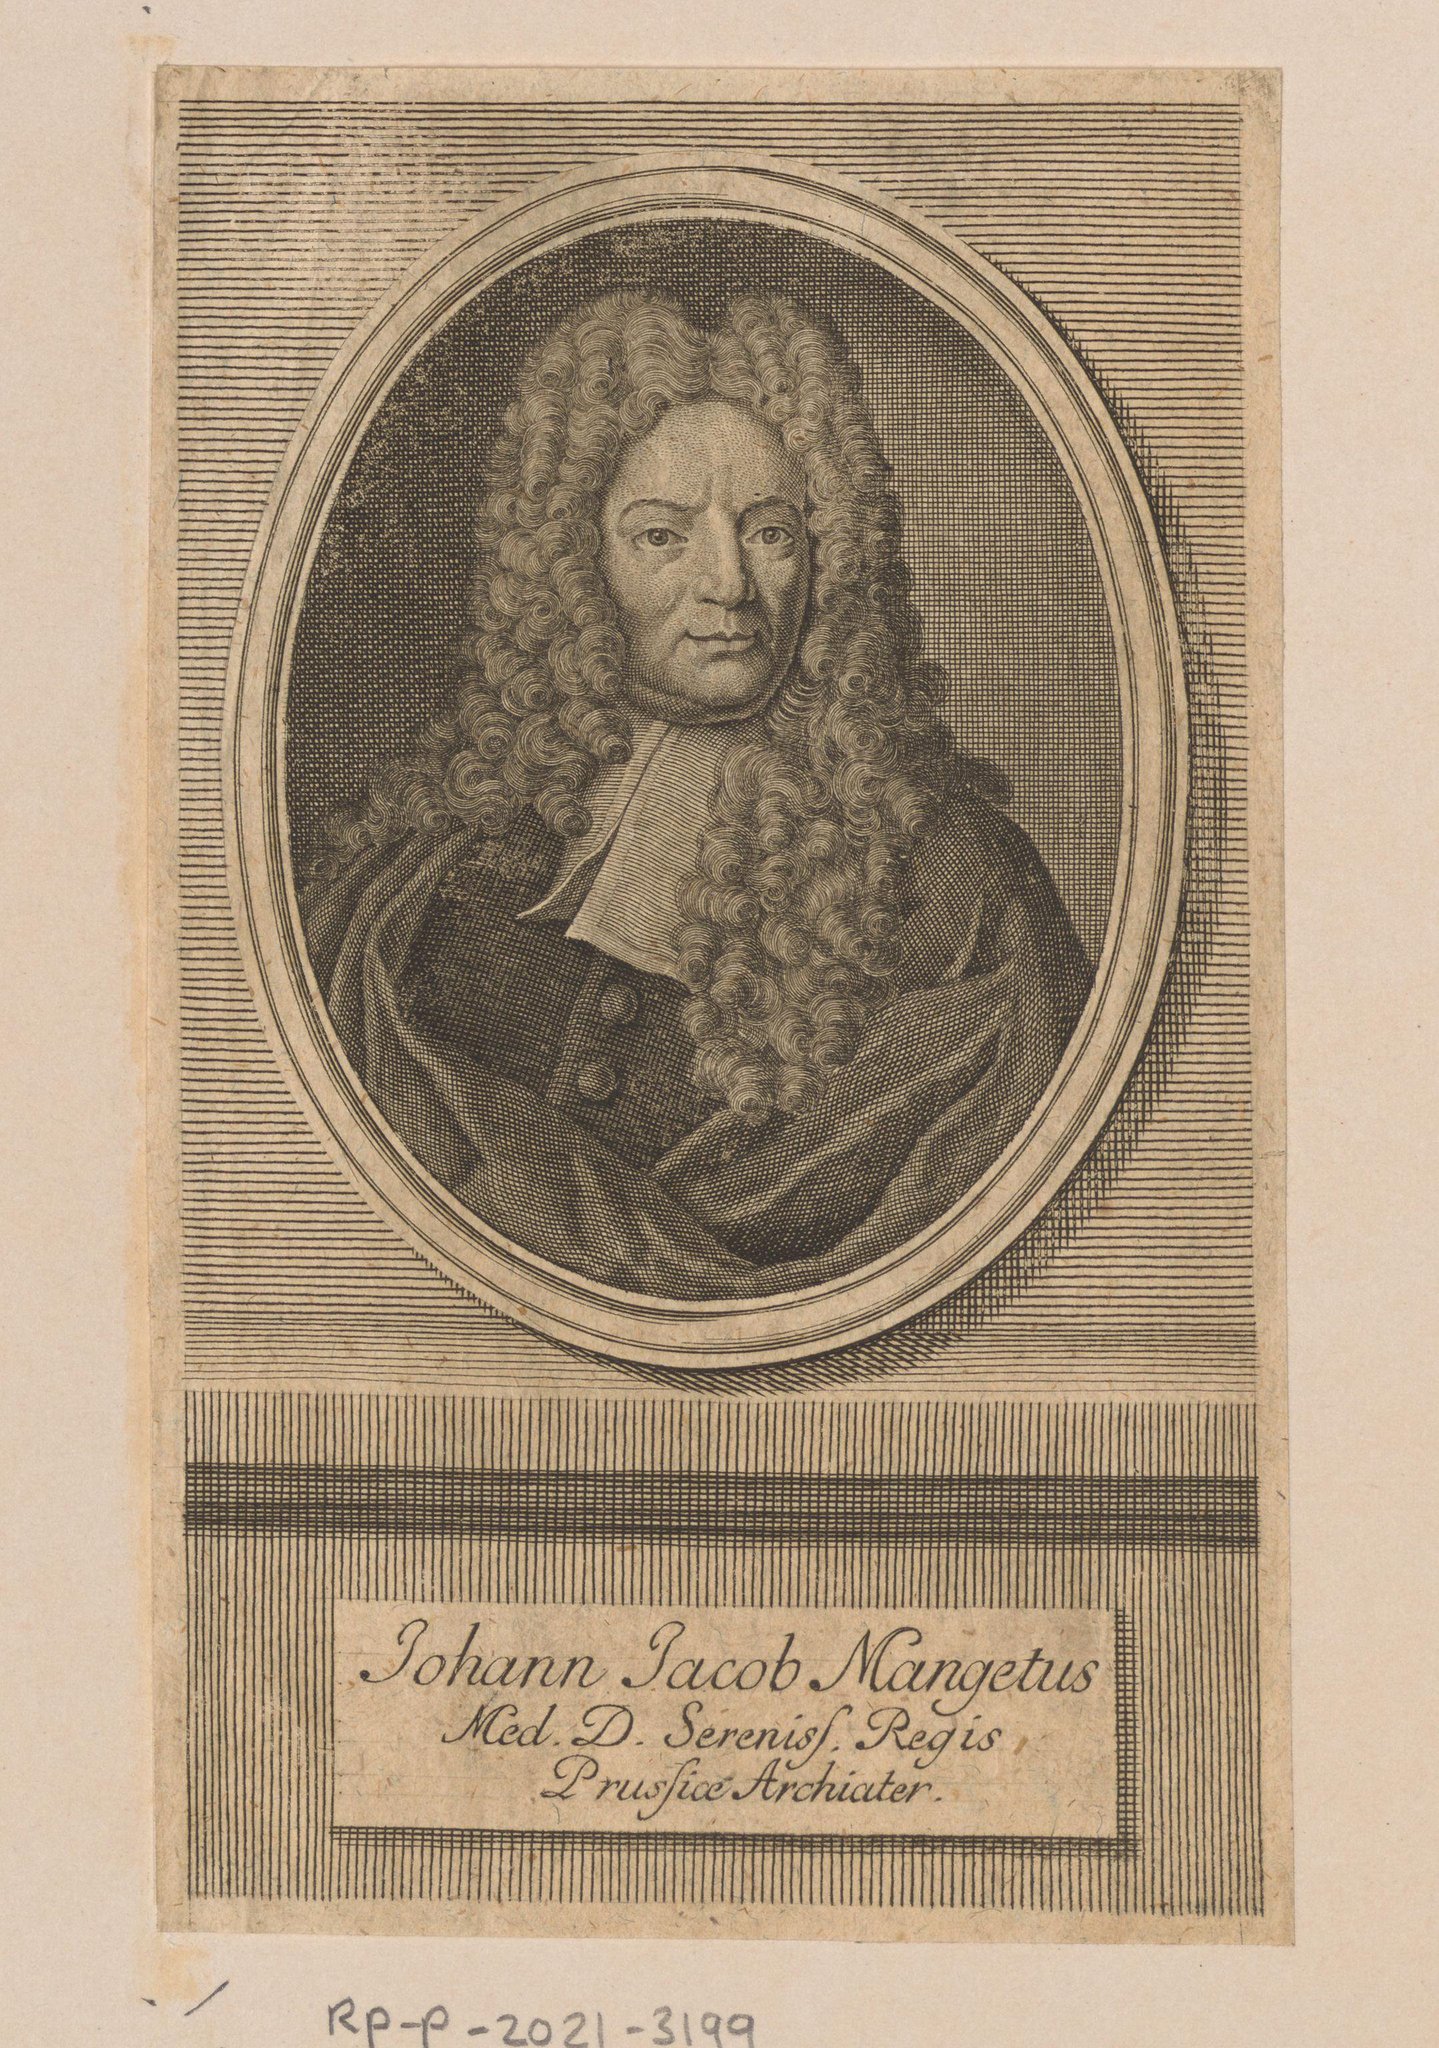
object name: book illustration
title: Portret van Jean-Jacques Manget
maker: martin bernigeroth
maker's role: print maker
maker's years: 1670-1733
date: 1717-1770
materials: paper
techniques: engraving, etching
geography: leipzig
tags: ornament ~ medallion, historical persons, portrait of a writer, physician, doctor (+ portrait of scholar, scientist)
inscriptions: number: ‘778’